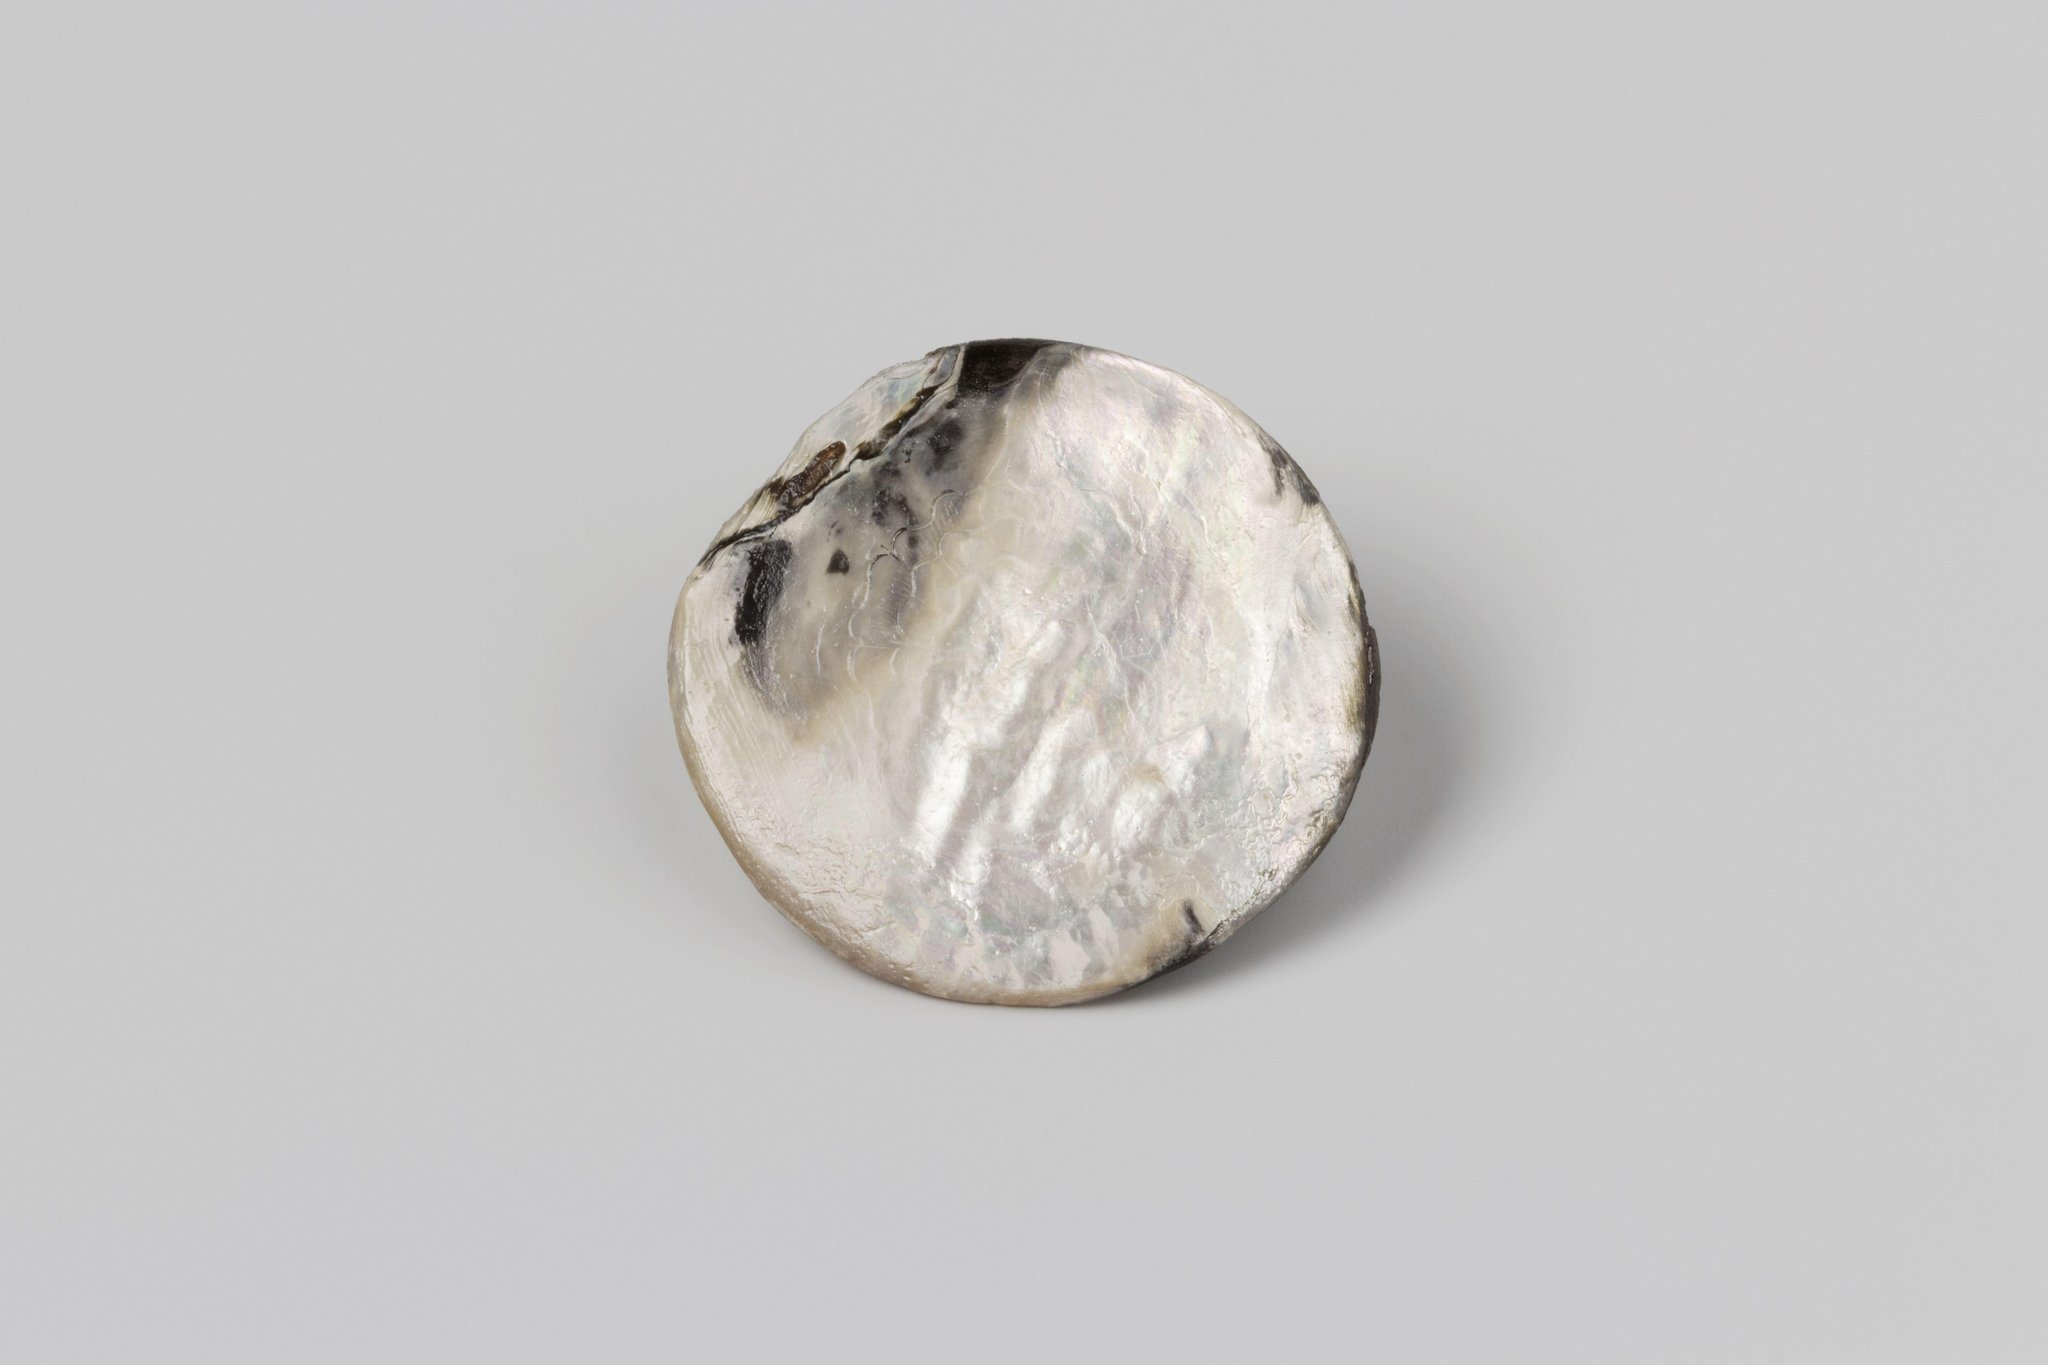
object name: button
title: Knoop van parelmoer uit het wrak van de in 1735 vergane Oost-Indiëvaarder 't Vliegend Hart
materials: mother of pearl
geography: middelburg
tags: 't vliegend hart (schip), verenigde oostindische compagnie